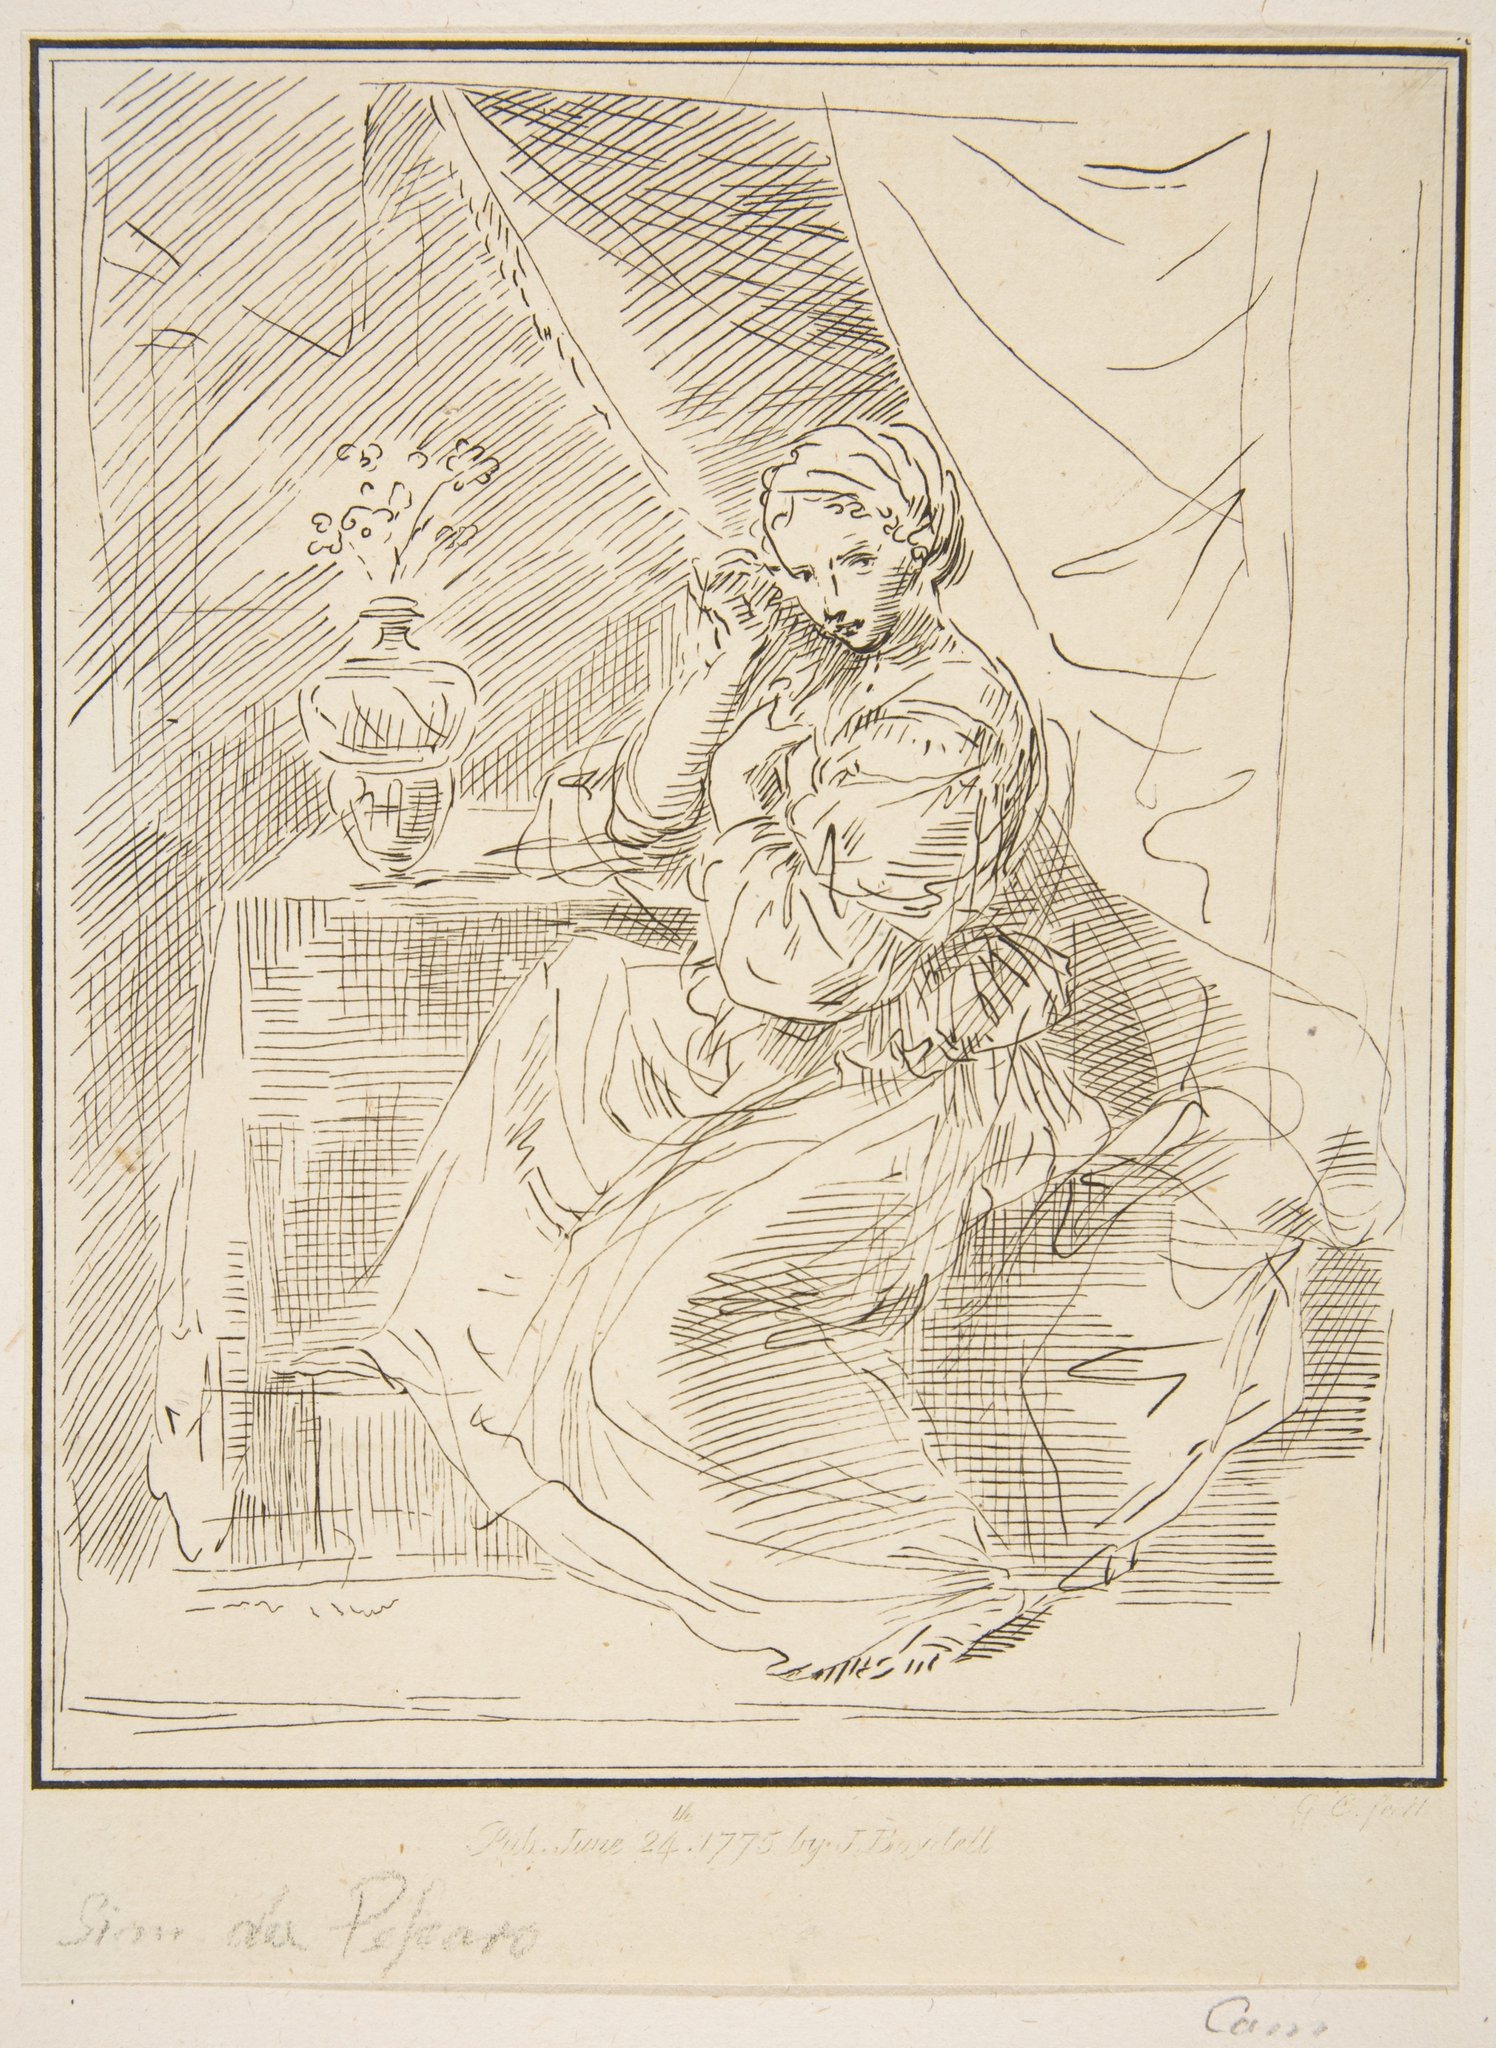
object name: print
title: A female figure seated beside a flower vase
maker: simone cantarini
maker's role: artist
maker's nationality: italian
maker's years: 1612-1648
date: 1775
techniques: etching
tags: women,vases